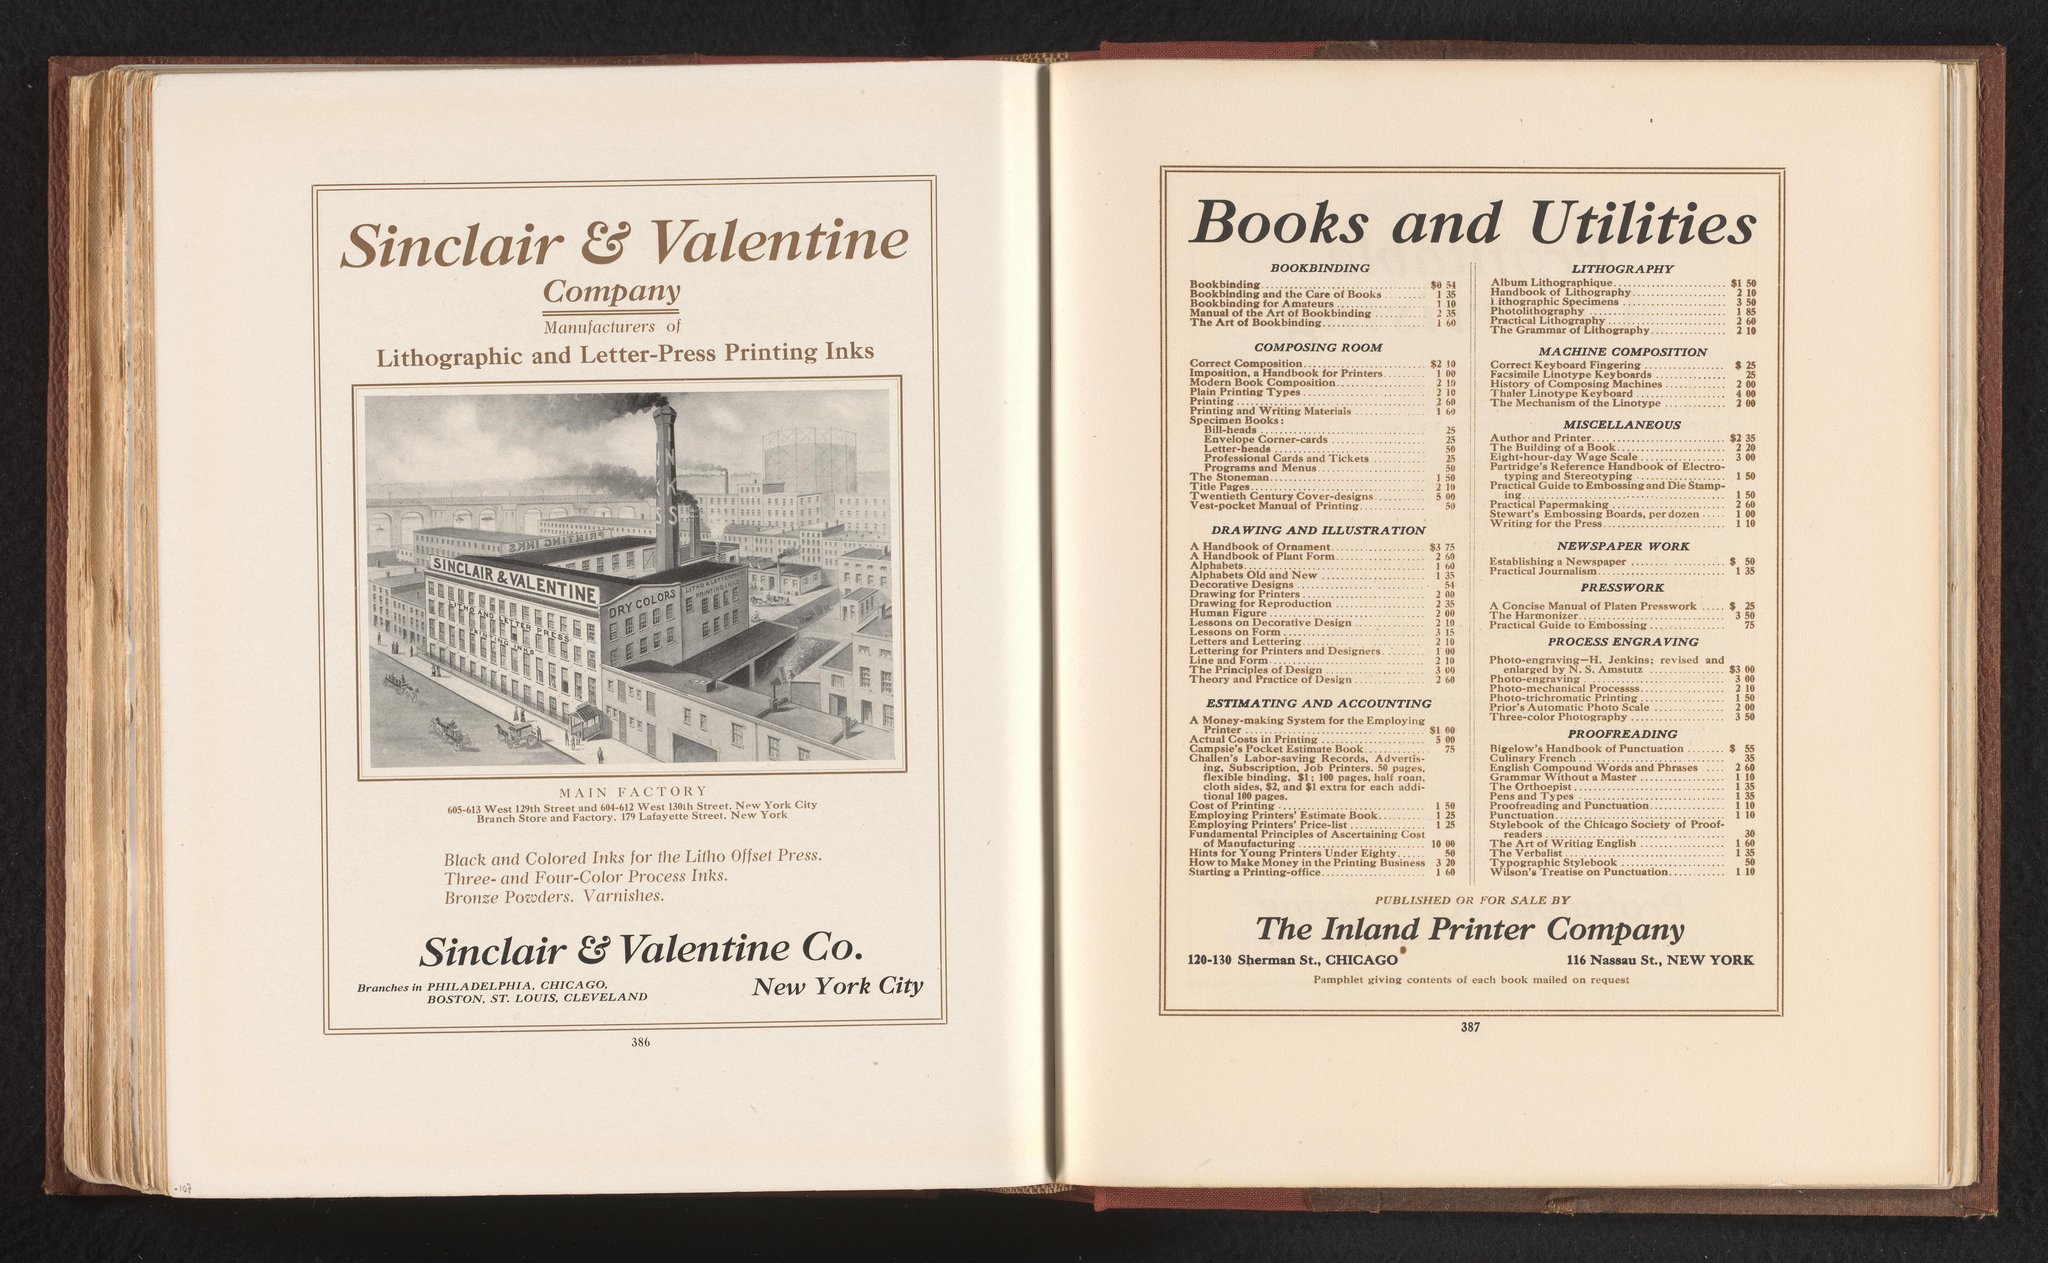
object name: page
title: Sinclair & Valentine Company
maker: Anonymous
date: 1904-1909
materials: paper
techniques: autotype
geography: new york city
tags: factory-building, advertising